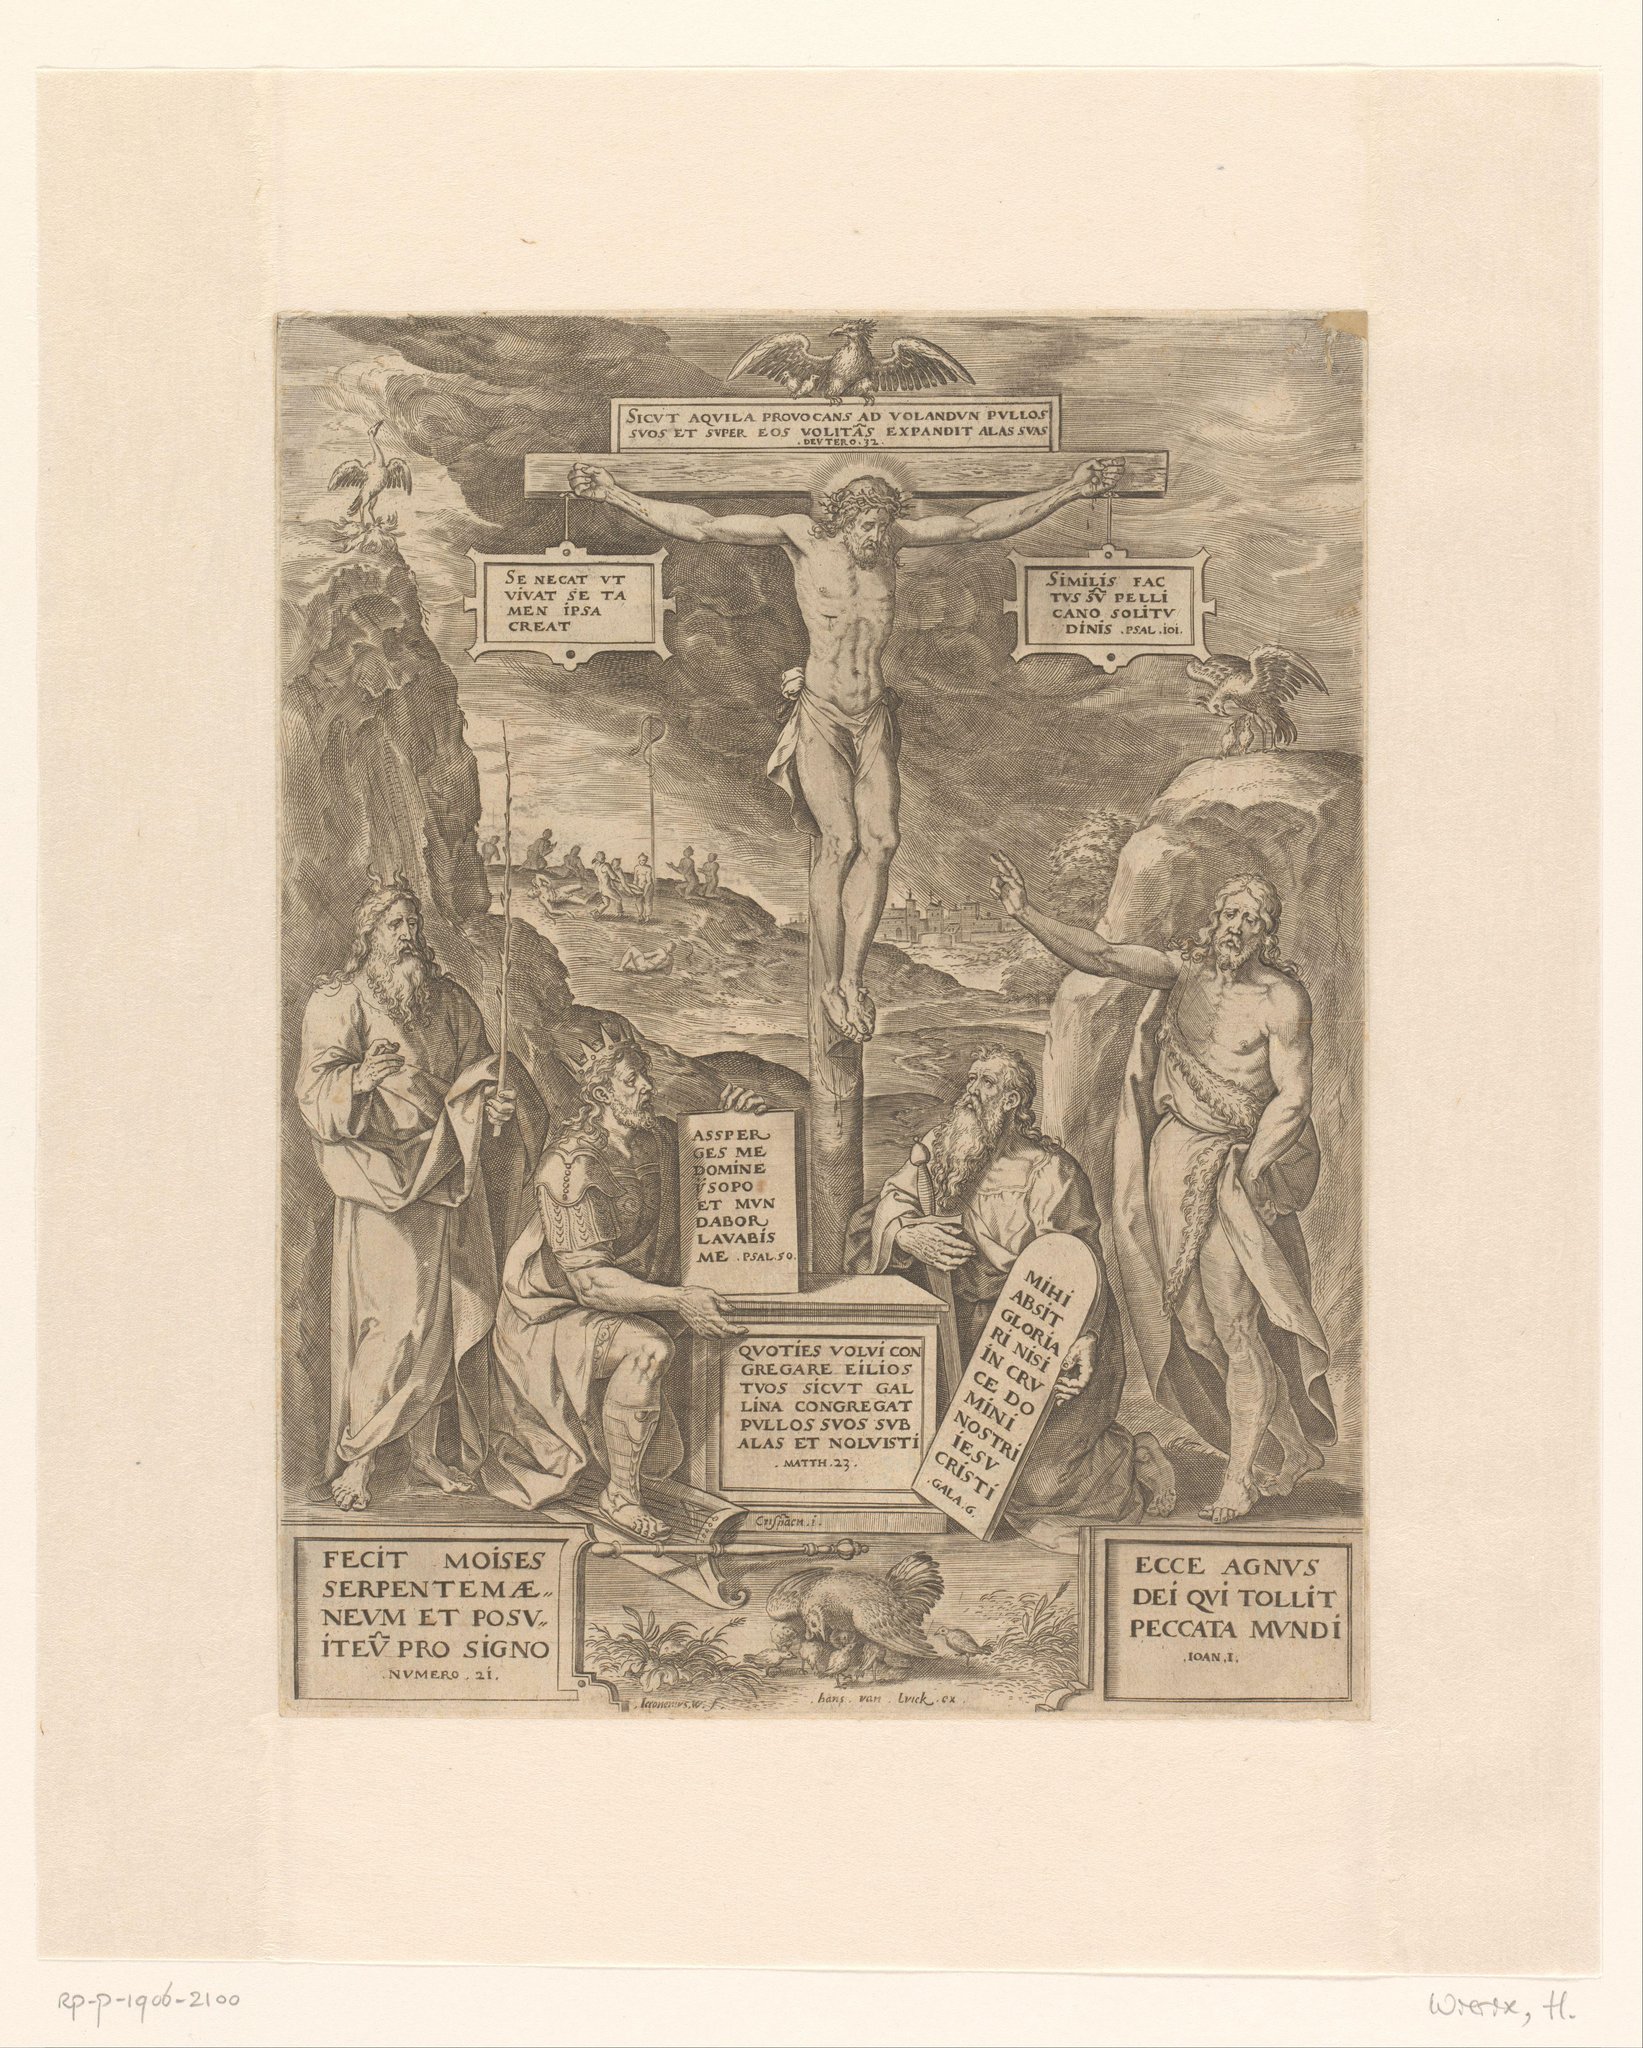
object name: print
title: Allegorie op de opstanding van Christus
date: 1565-1586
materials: paper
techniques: engraving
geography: antwerp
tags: crucified christ, with particular persons under the cross, john the baptist; possible attributes: book, reed cross, baptismal cup, honeycomb, lamb, staff, fowl (cock, hen, chicken, etc.) (+ feeding and care of young), symbolic representations of the resurrection, david (not in biblical context); possible attributes: crown, harp, symbols of christ ~ animals, moses (not in biblical context); possible attributes: rays of light or horns on his head, rod, tables of the law, a serpent of brass is made and is set on a pole, fabulous animals ~ birds: phoenix, the apostle paul of tarsus; possible attributes: book, scroll, sword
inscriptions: number: ‘AP 389’, collector's mark: Lugt 2228, collector's mark: Lugt 1337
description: Christus hangt aan het kruis. Aan de voet van het kruis Mozes en koning David (links) en Paulus en Johannes de Doper (rechts). Rondom diverse verwijzingen naar de opstanding van Christus: boven het kruis en aan de rechterzijde een adelaar, onderaan een kip met haar kuikens, en aan de linkerzijde een feniks. Op de achtergrond de oprichting van de koperen slang door Mozes. Links en rechtsonder Bijbelcitaten uit Num. 21 en Joh. 1 in het Latijn.